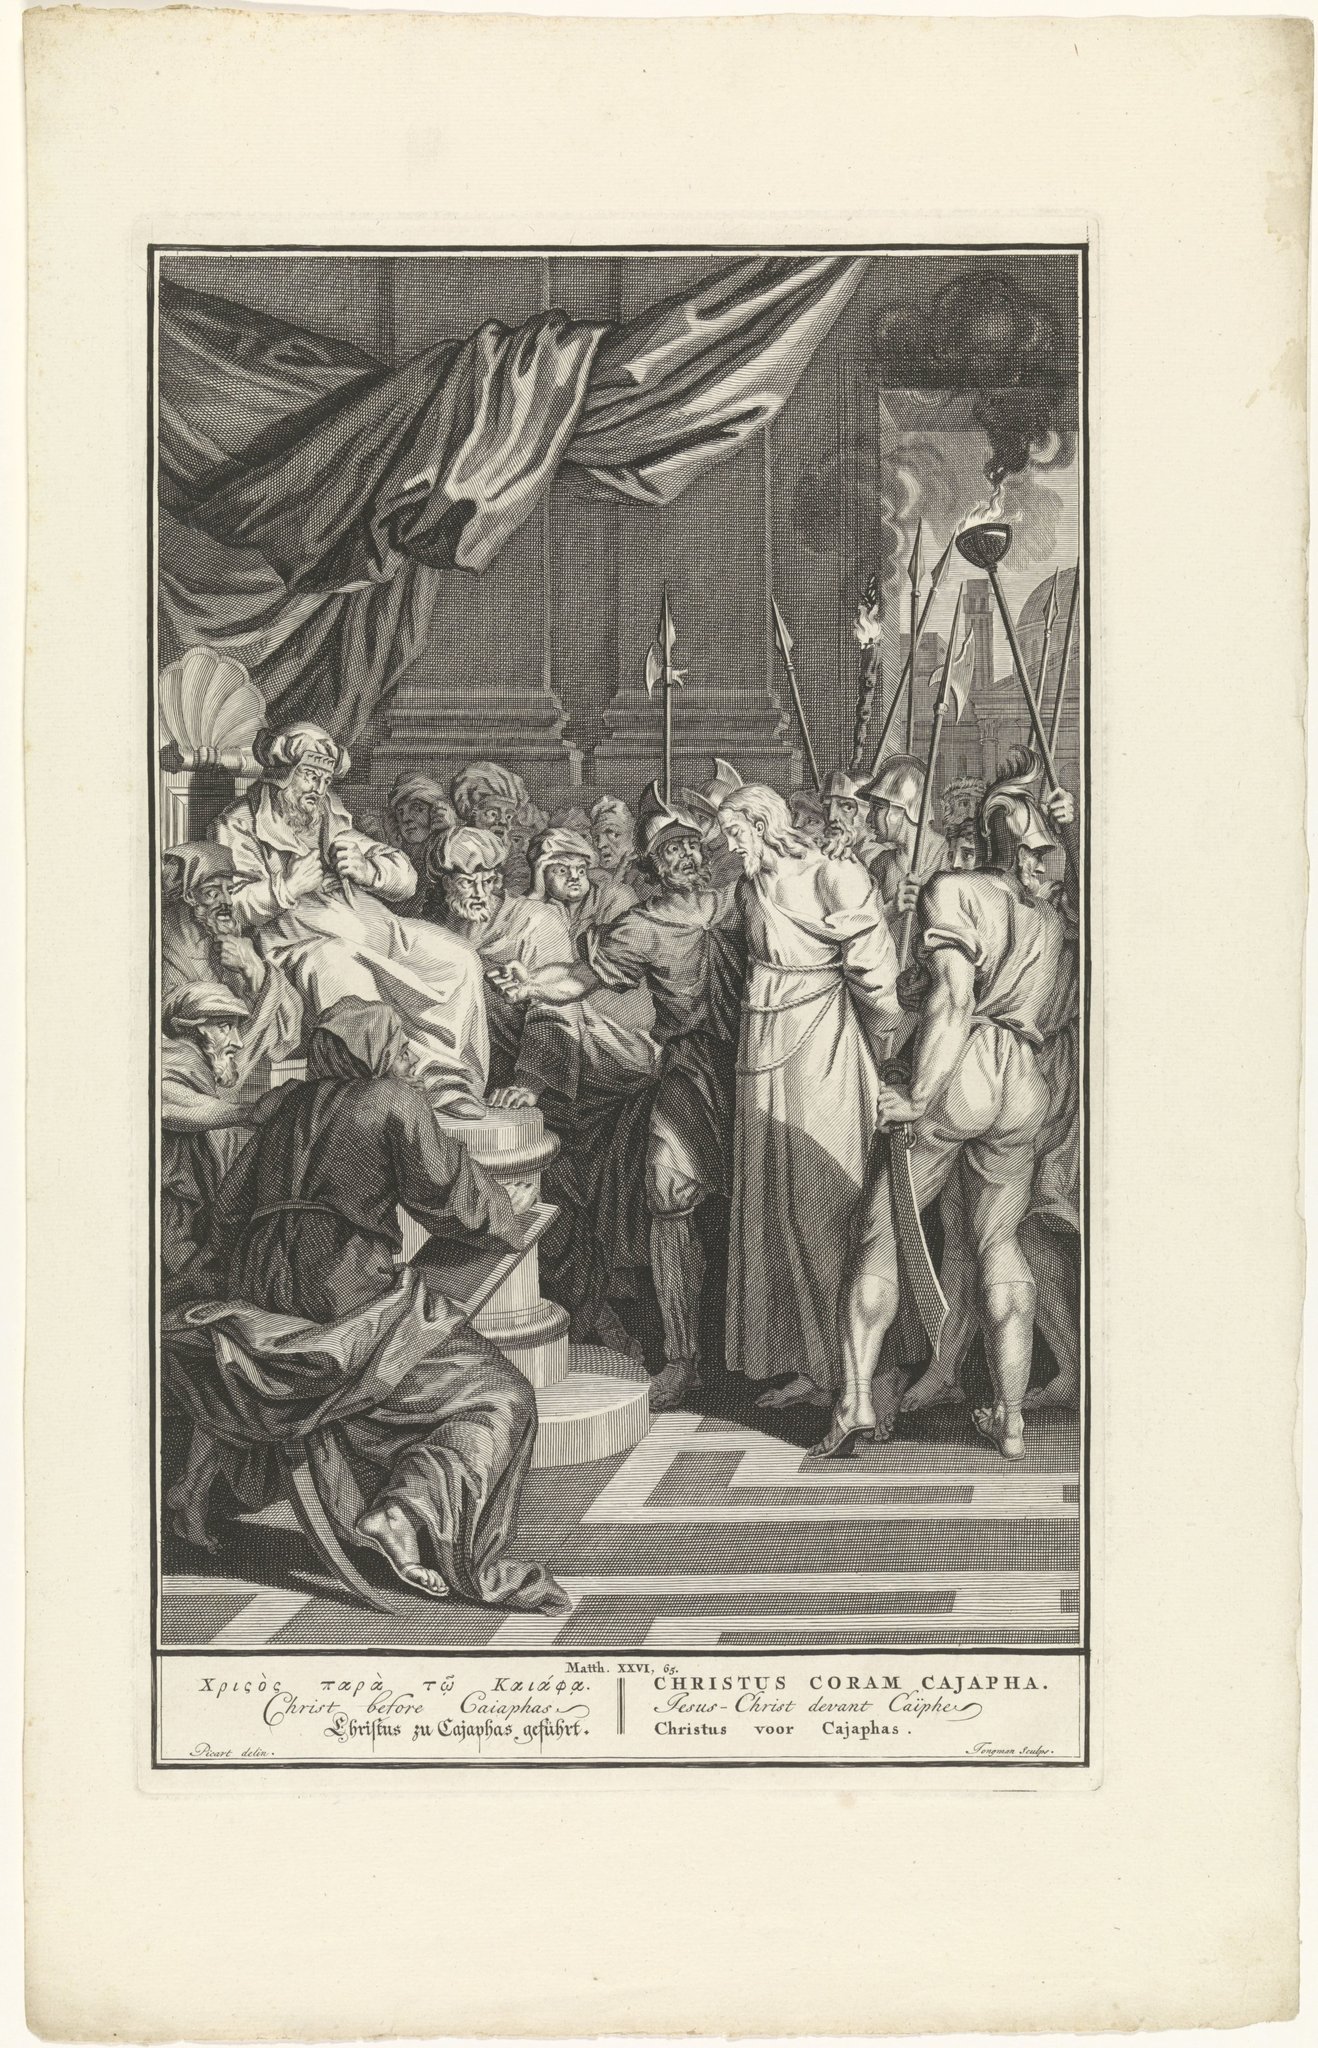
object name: book illustration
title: Christus voor Kajafas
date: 1705-1720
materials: paper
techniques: engraving, etching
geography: amsterdam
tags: christ before the sanhedrin with caiaphas as high priest, and possibly annas; maybe a soldier about to strike christ because he keeps silent (matthew 26:57-66; mark 14:53-64; luke 22:54, 22:66-71)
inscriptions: collector's mark: Lugt 2228, inscription: ‘Utrechts Fundatie Huijs’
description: Prent oorspronkelijk bedoeld voor: Figures de la Bible. Amsterdam: Bernard Picart, 1720. Prent ook gebruikt in: Taferelen der voornaamste geschiedenissen van het Oude en Nieuwe Testament (...) door de vermaarde kunstenaars Hoet, Houbraken, en Picart getekent (...) en met beschrijvingen uitgebreid. Den Haag: Pieter de Hondt, 1728.